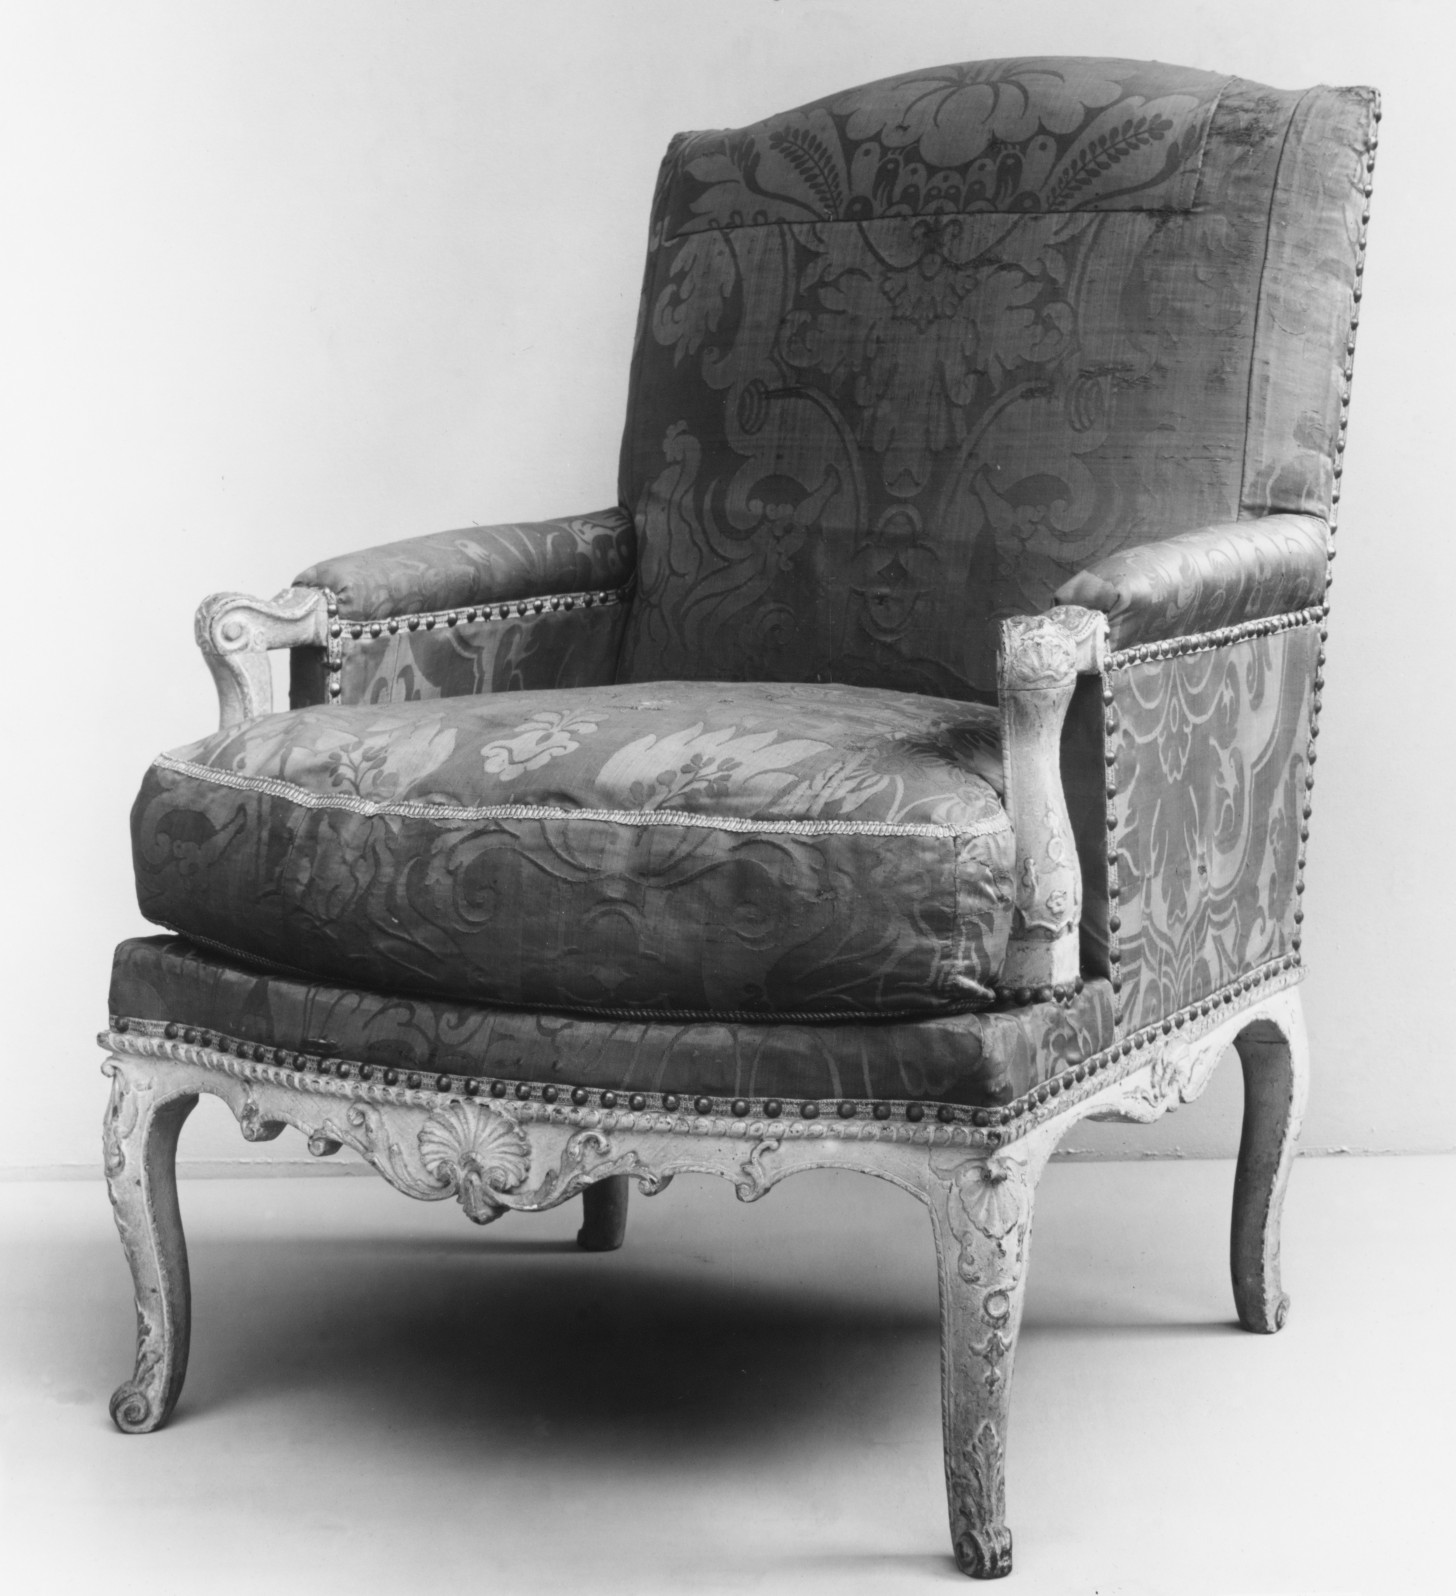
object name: armchair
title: Armchair (bergère)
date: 1701-1725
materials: wood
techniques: carving, damask, painting